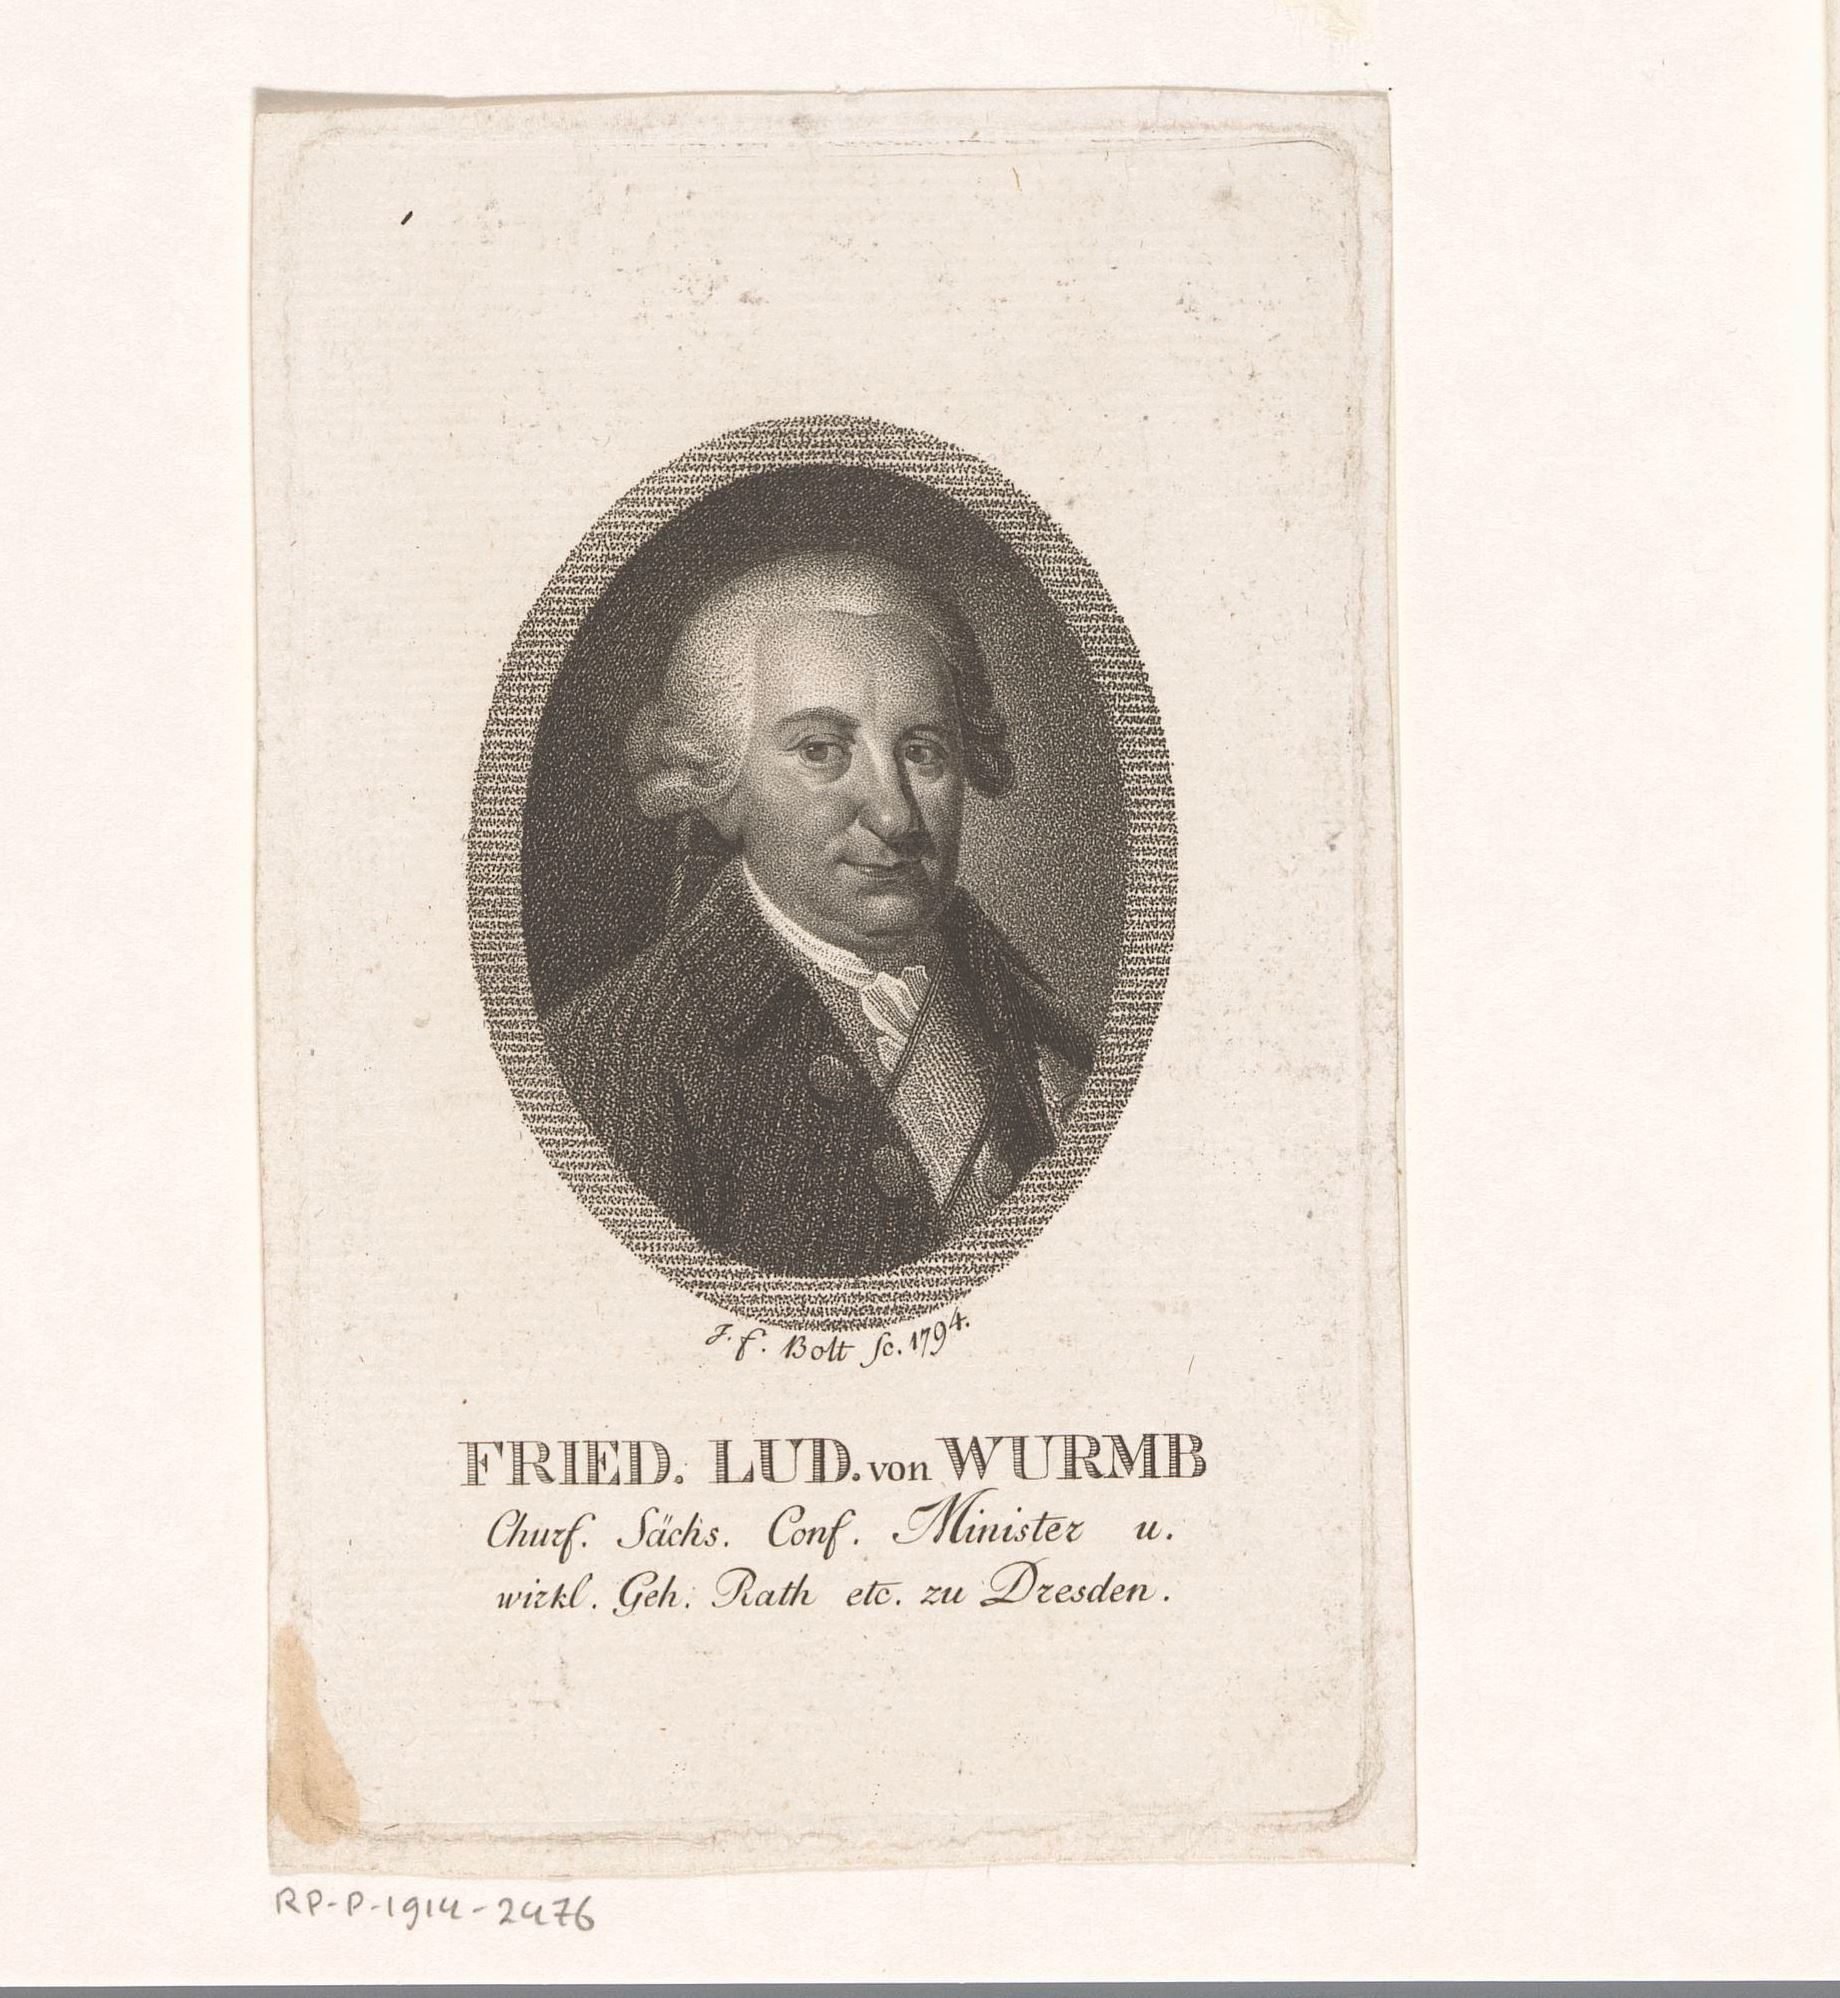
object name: print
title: Portret van Friedrich Ludwig von Wurmb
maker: johann friedrich bolt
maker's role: print maker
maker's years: 1769-1836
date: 1794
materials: paper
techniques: stippling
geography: berlin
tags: historical persons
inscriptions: collector's mark: Lugt 2228